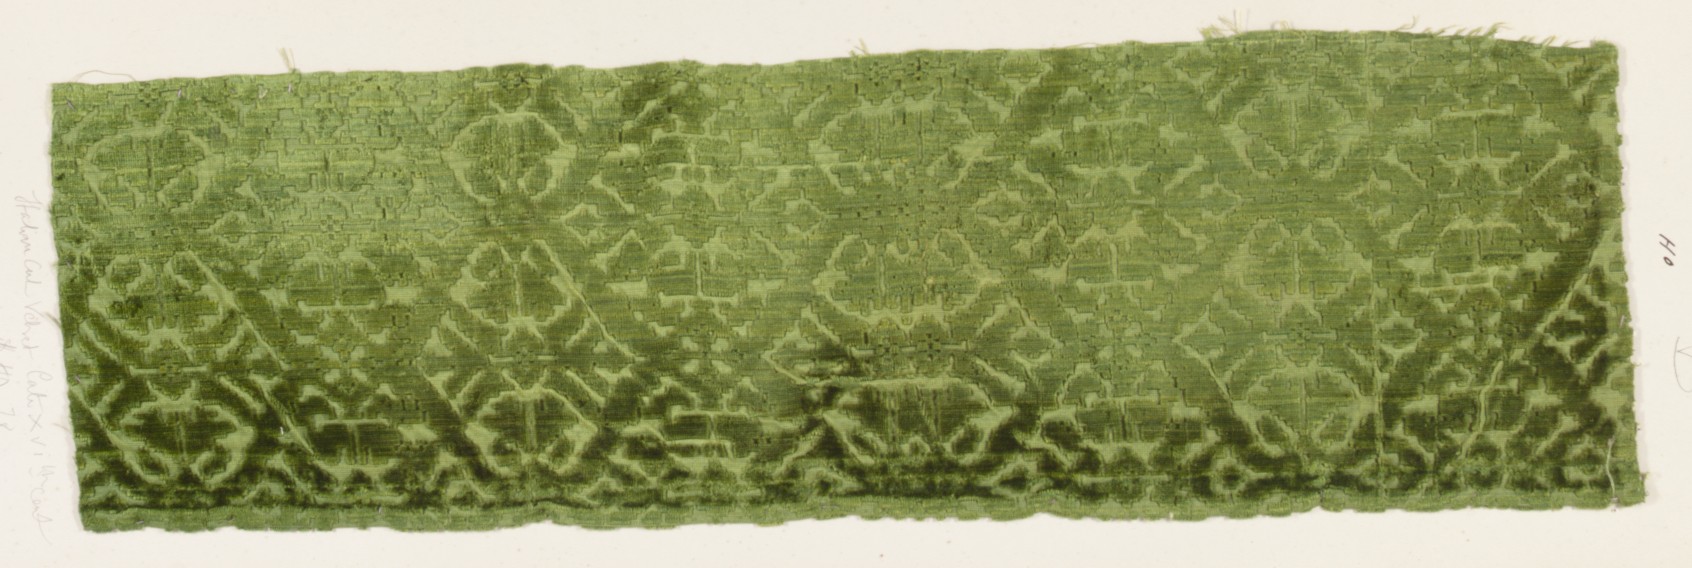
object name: fragment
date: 1567-1600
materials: silk